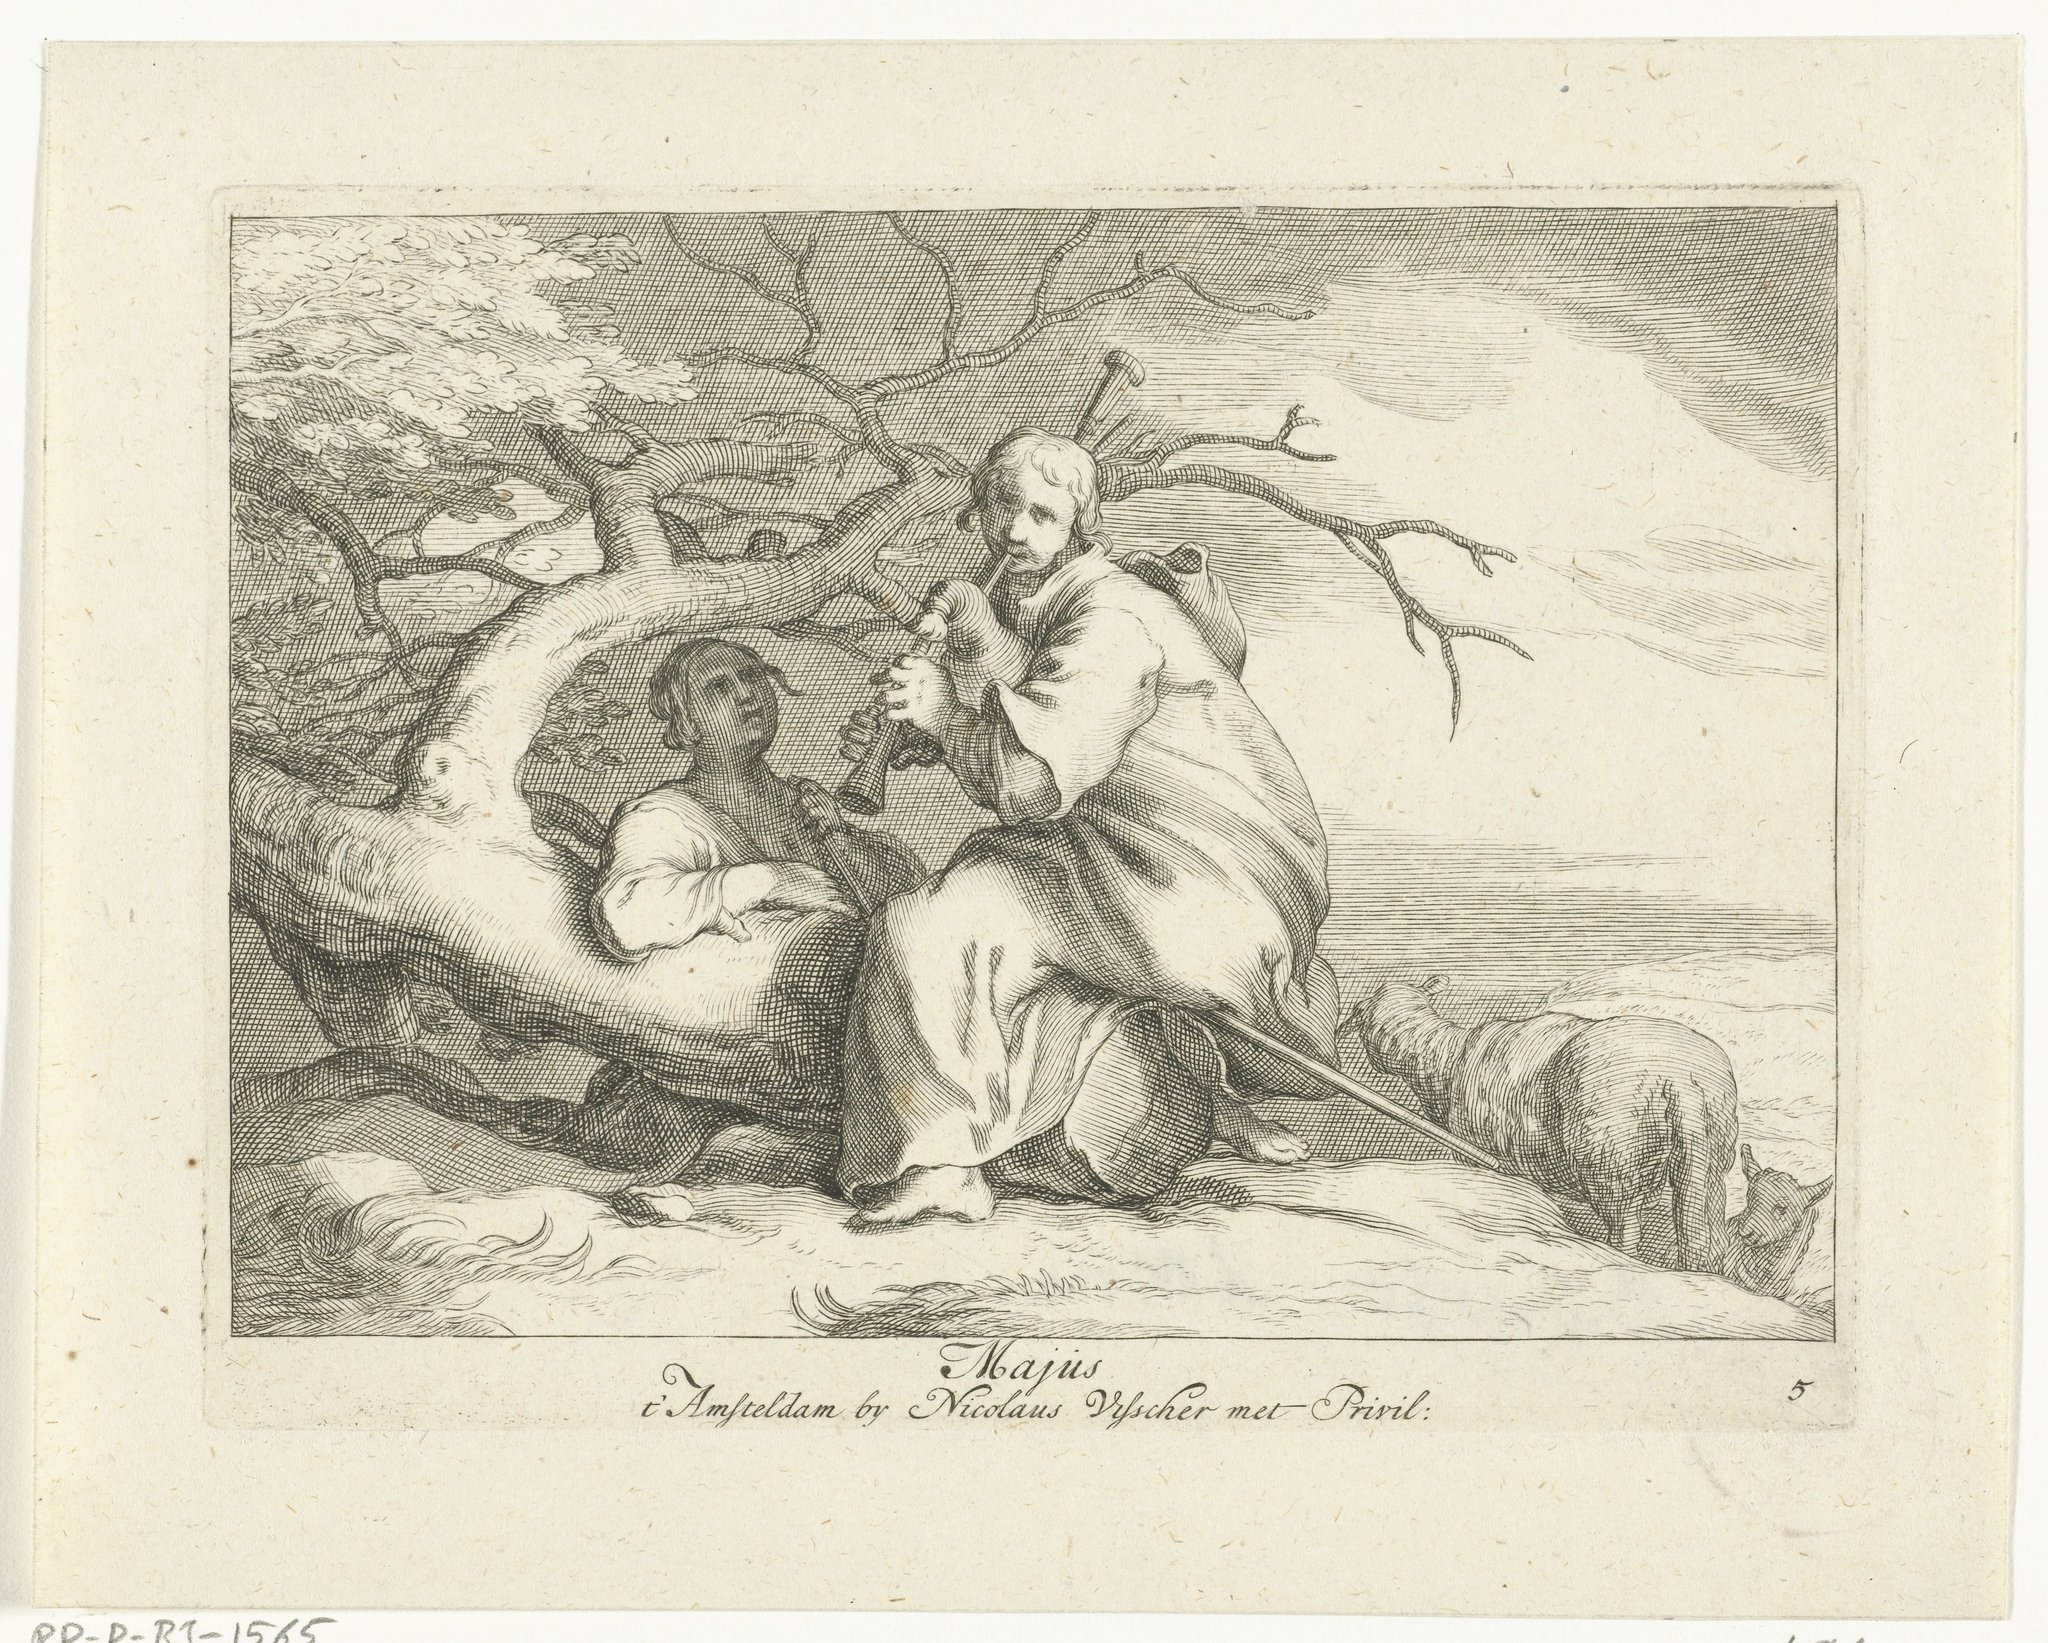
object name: print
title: De Maanden van het Jaar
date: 1635-1670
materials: paper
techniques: engraving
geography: utrecht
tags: transverse flute - cc - out of doors, herding, herdsman, herdswoman, shepherd, shepherdess, cowherd, etc., may and its 'labours'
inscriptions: collector's mark: Lugt 240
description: Op een boomstronk speelt een herder fluit voor een meisje. Op de achtergrond twee schapen.